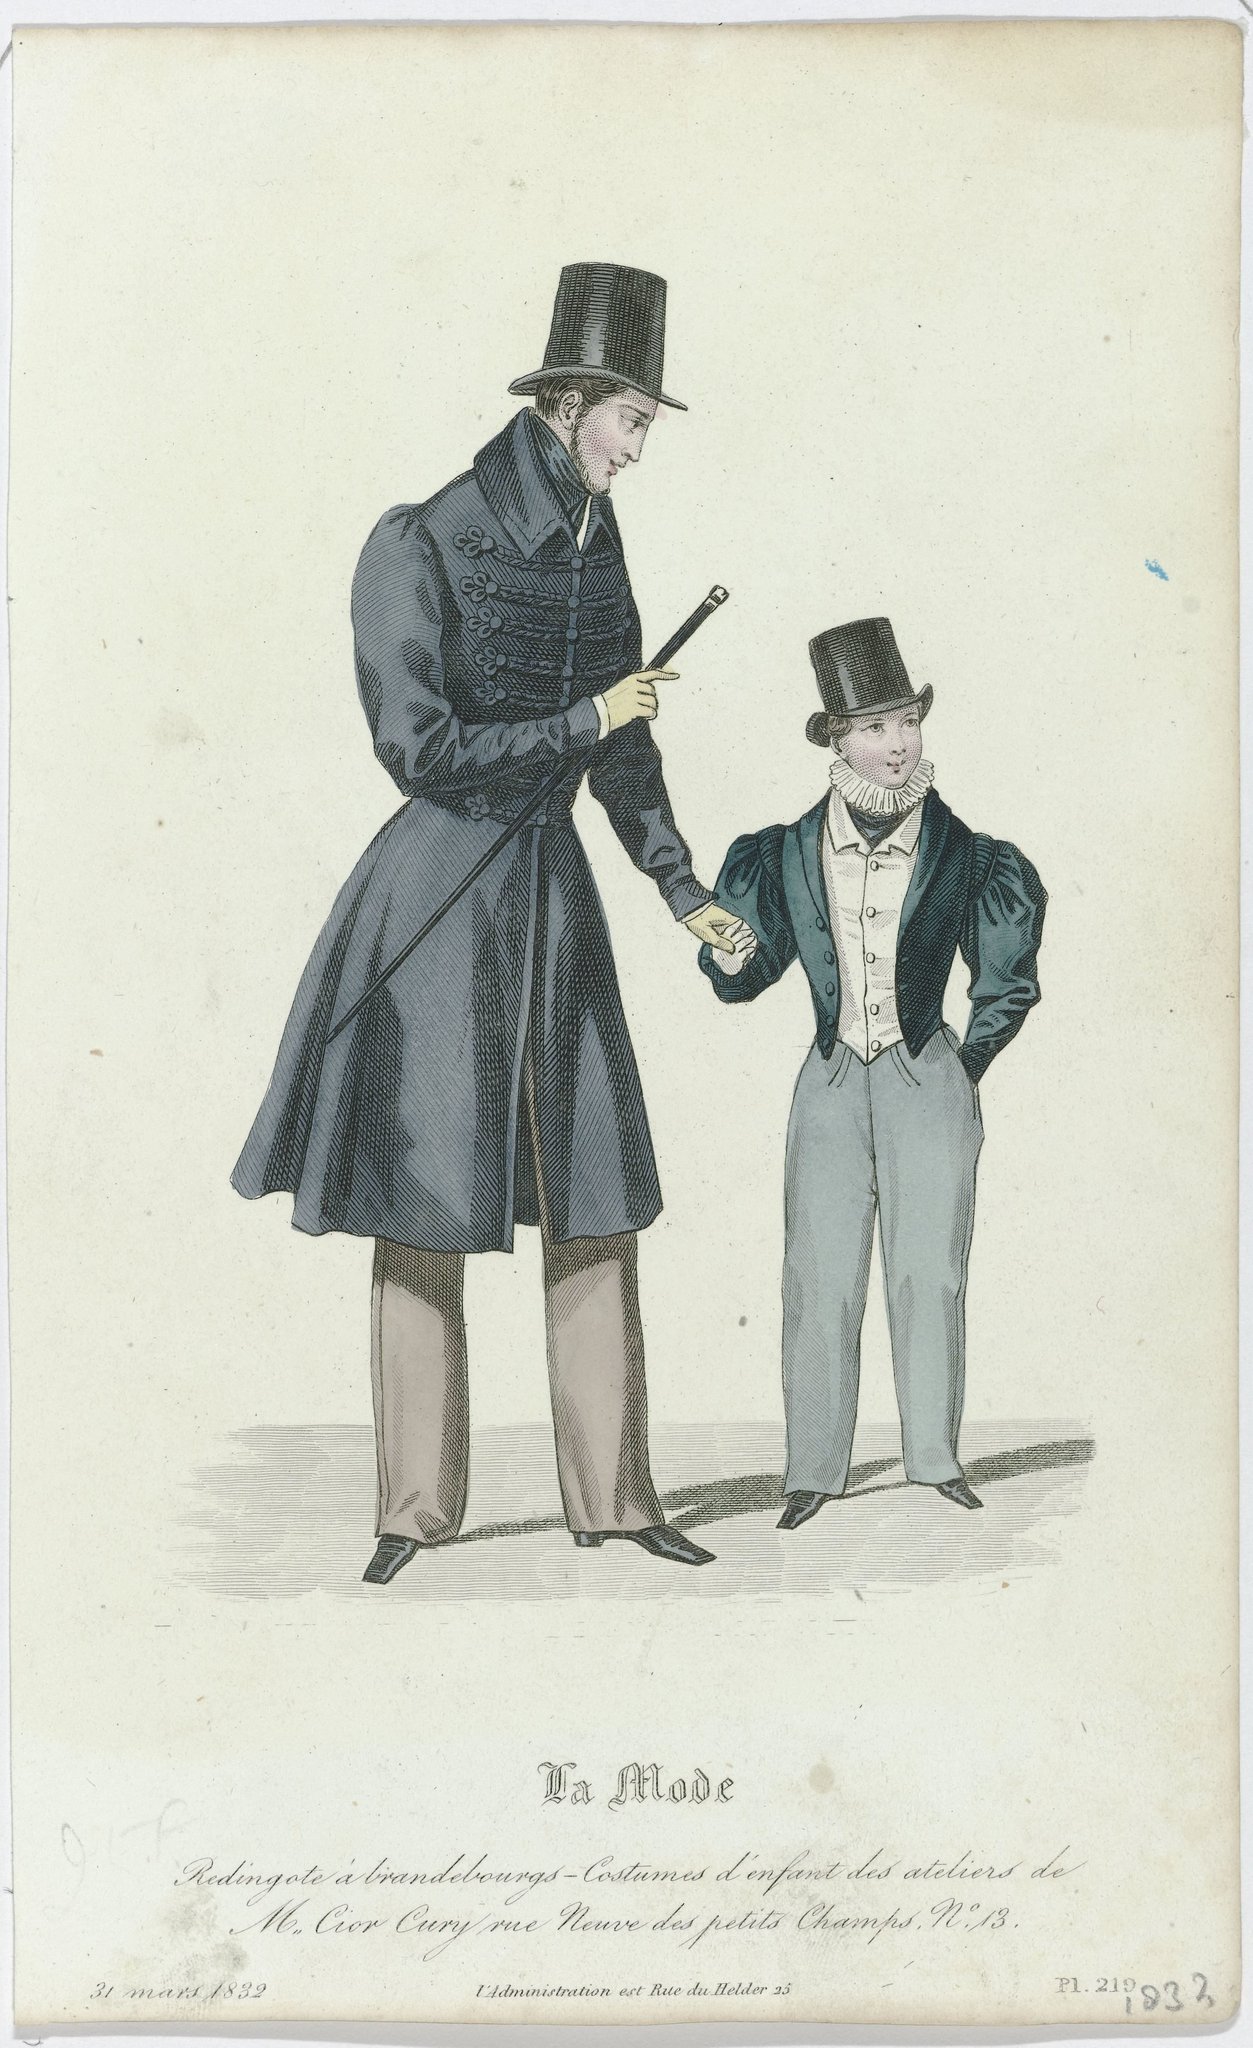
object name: fashion print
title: La Mode, 31 mars 1832, Pl. 219 : Redingote à brandebourgs-Costumes (...)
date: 1832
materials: paper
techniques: hand coloring, engraving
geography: paris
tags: neck-gear ~ clothing (+ men's clothes), trousers, breeches (+ boys' clothes), trousers, breeches, etc. (pantalon) (+ men's clothes), clothing for the upper part of the body (+ boys' clothes), head-gear (+ boys' clothes), neck-gear ~ clothing (+ boys' clothes), coat (+ men's clothes), fashion plates, walking-stick, staff, cane (+ men's clothes)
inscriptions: caption: ‘Redingote à brandebourgs - Costumes d'enfant des ateliers de M"Cior Cury rue Neuve des petits Champs, No. 13.’, address: ‘L'Administration est Rue du Helder 25.’, title: ‘La Mode.’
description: Redingote met brandebourgs. Lange broek. Accessoires: hoge hoed, handschoenen, wandelstok, schoenen met hakken en vierkante neuzen. Het kostuum van de jongen komt uit het atelier van M.Cior-Cury. Jas, vest en lange broek. Geplooide kraag. Hoge hoed. Schoenen met vierkante neuzen. Prent uit het modetijdschrift La Mode (1829-1855), kopie naar Pl . 2967, 15 mars 1832, uit Journal des Dames et des Modes, Parijs, 1797-1839.